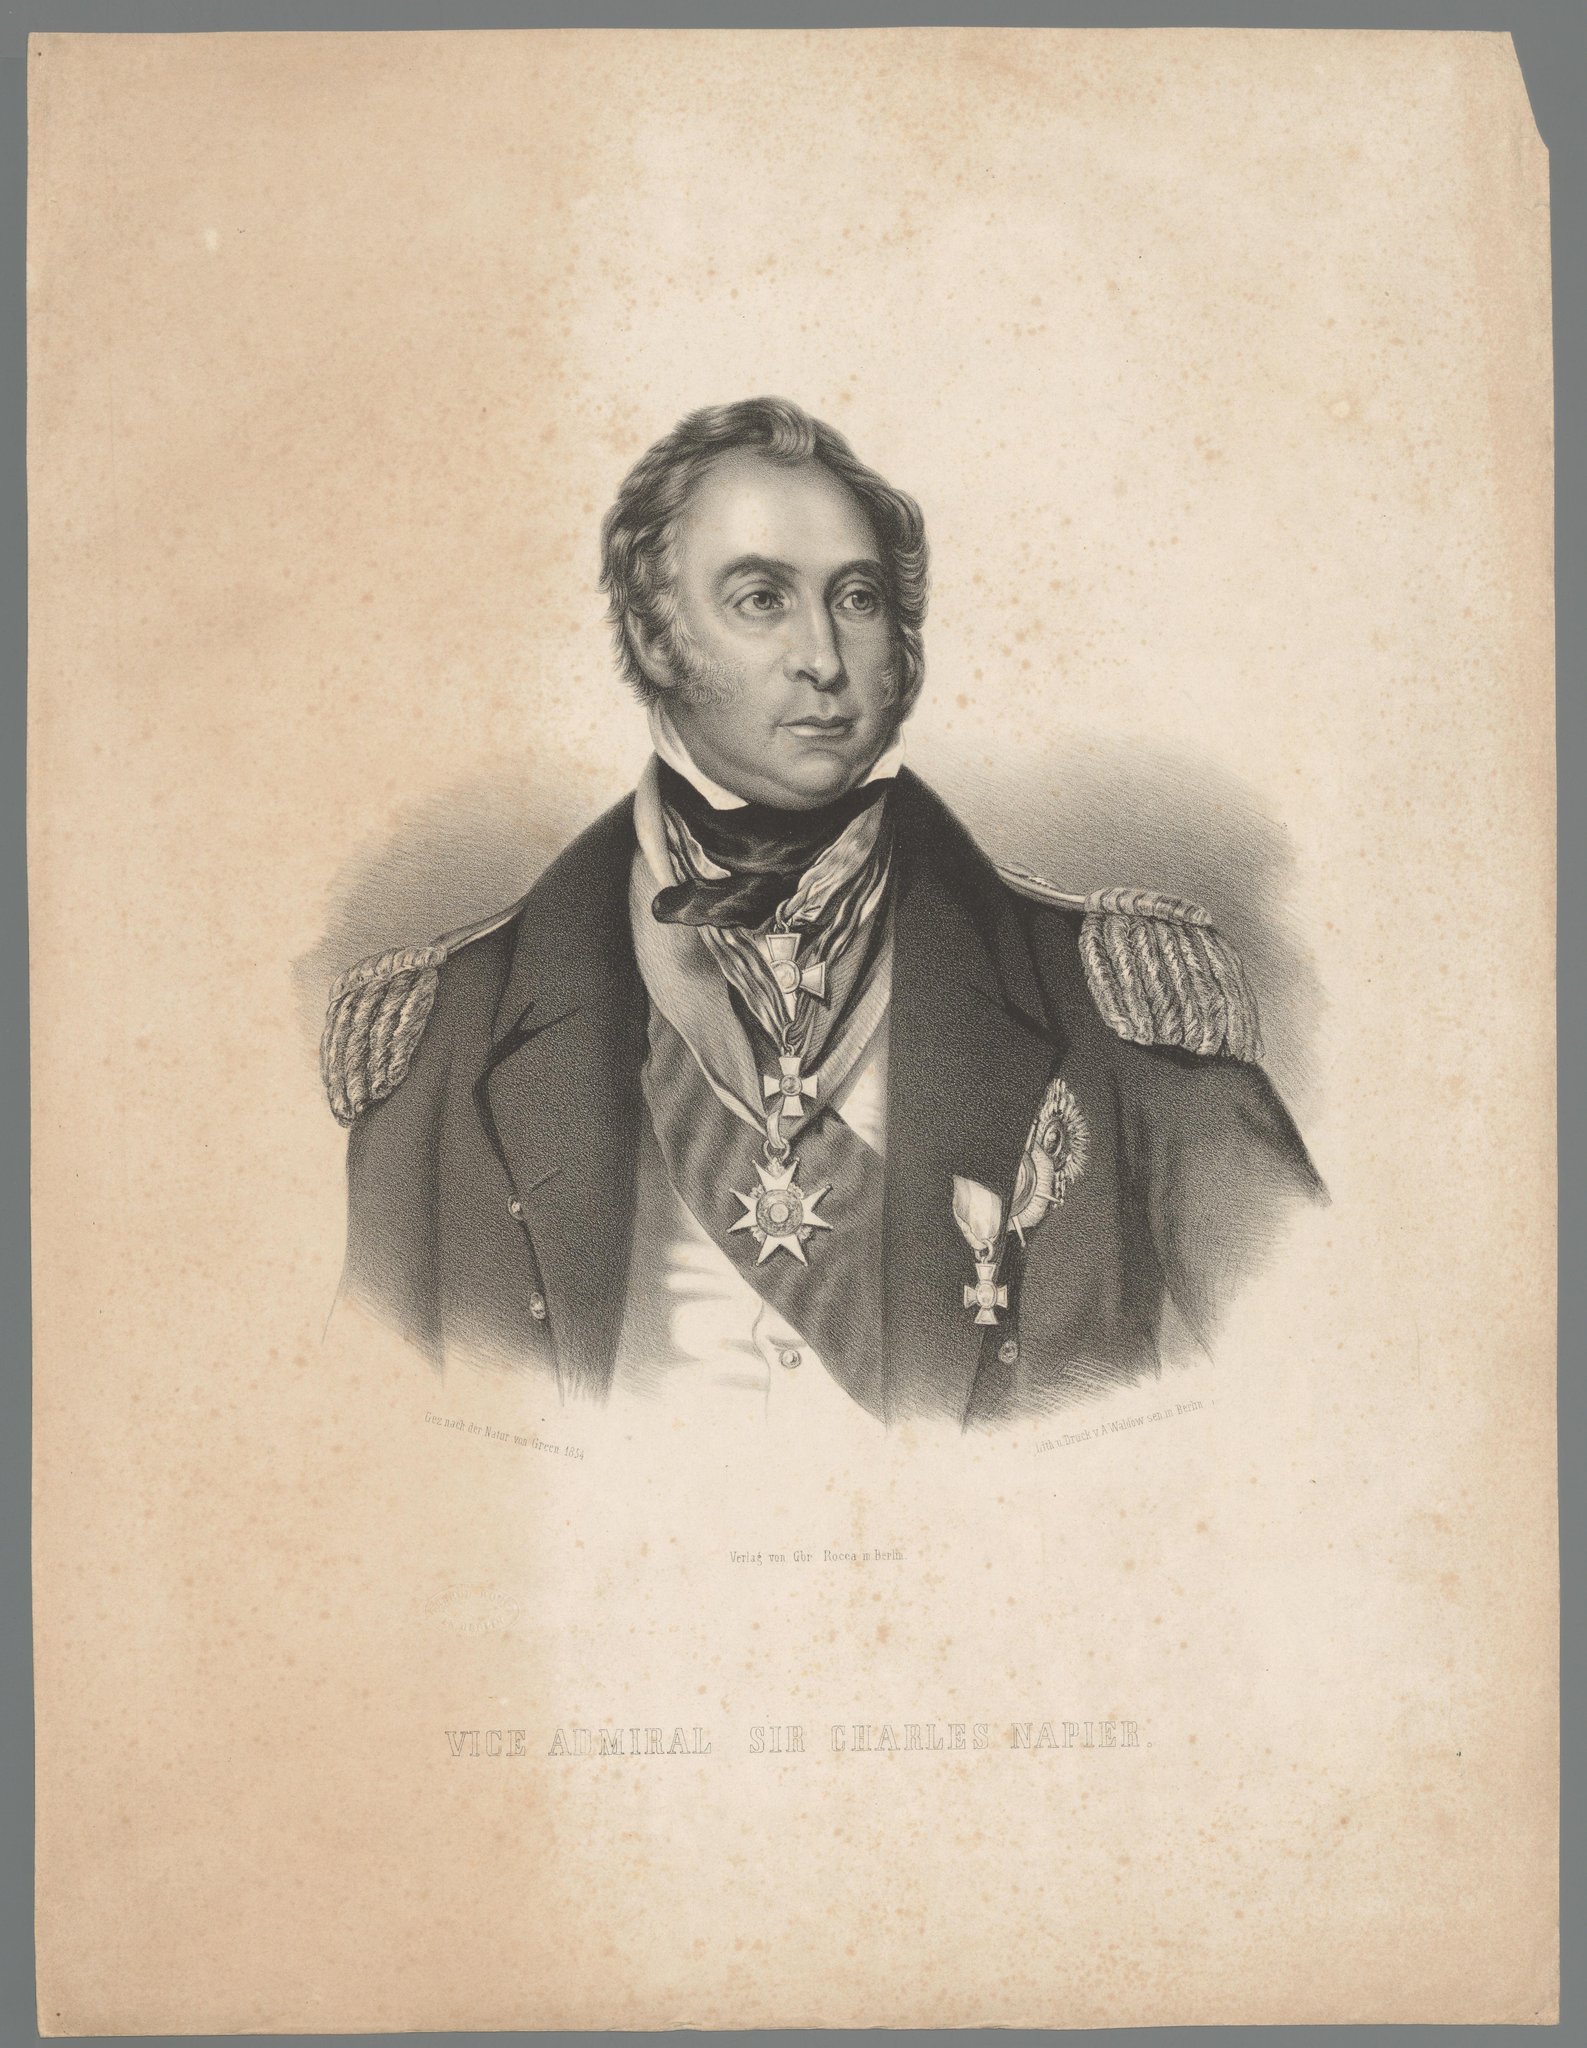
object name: print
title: Portret van Charles John Napier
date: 1854-1863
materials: paper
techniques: lithograph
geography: berlin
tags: naval officer, adult man, historical persons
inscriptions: collector's mark: Lugt 2228, check stamp: Lugt 2141c